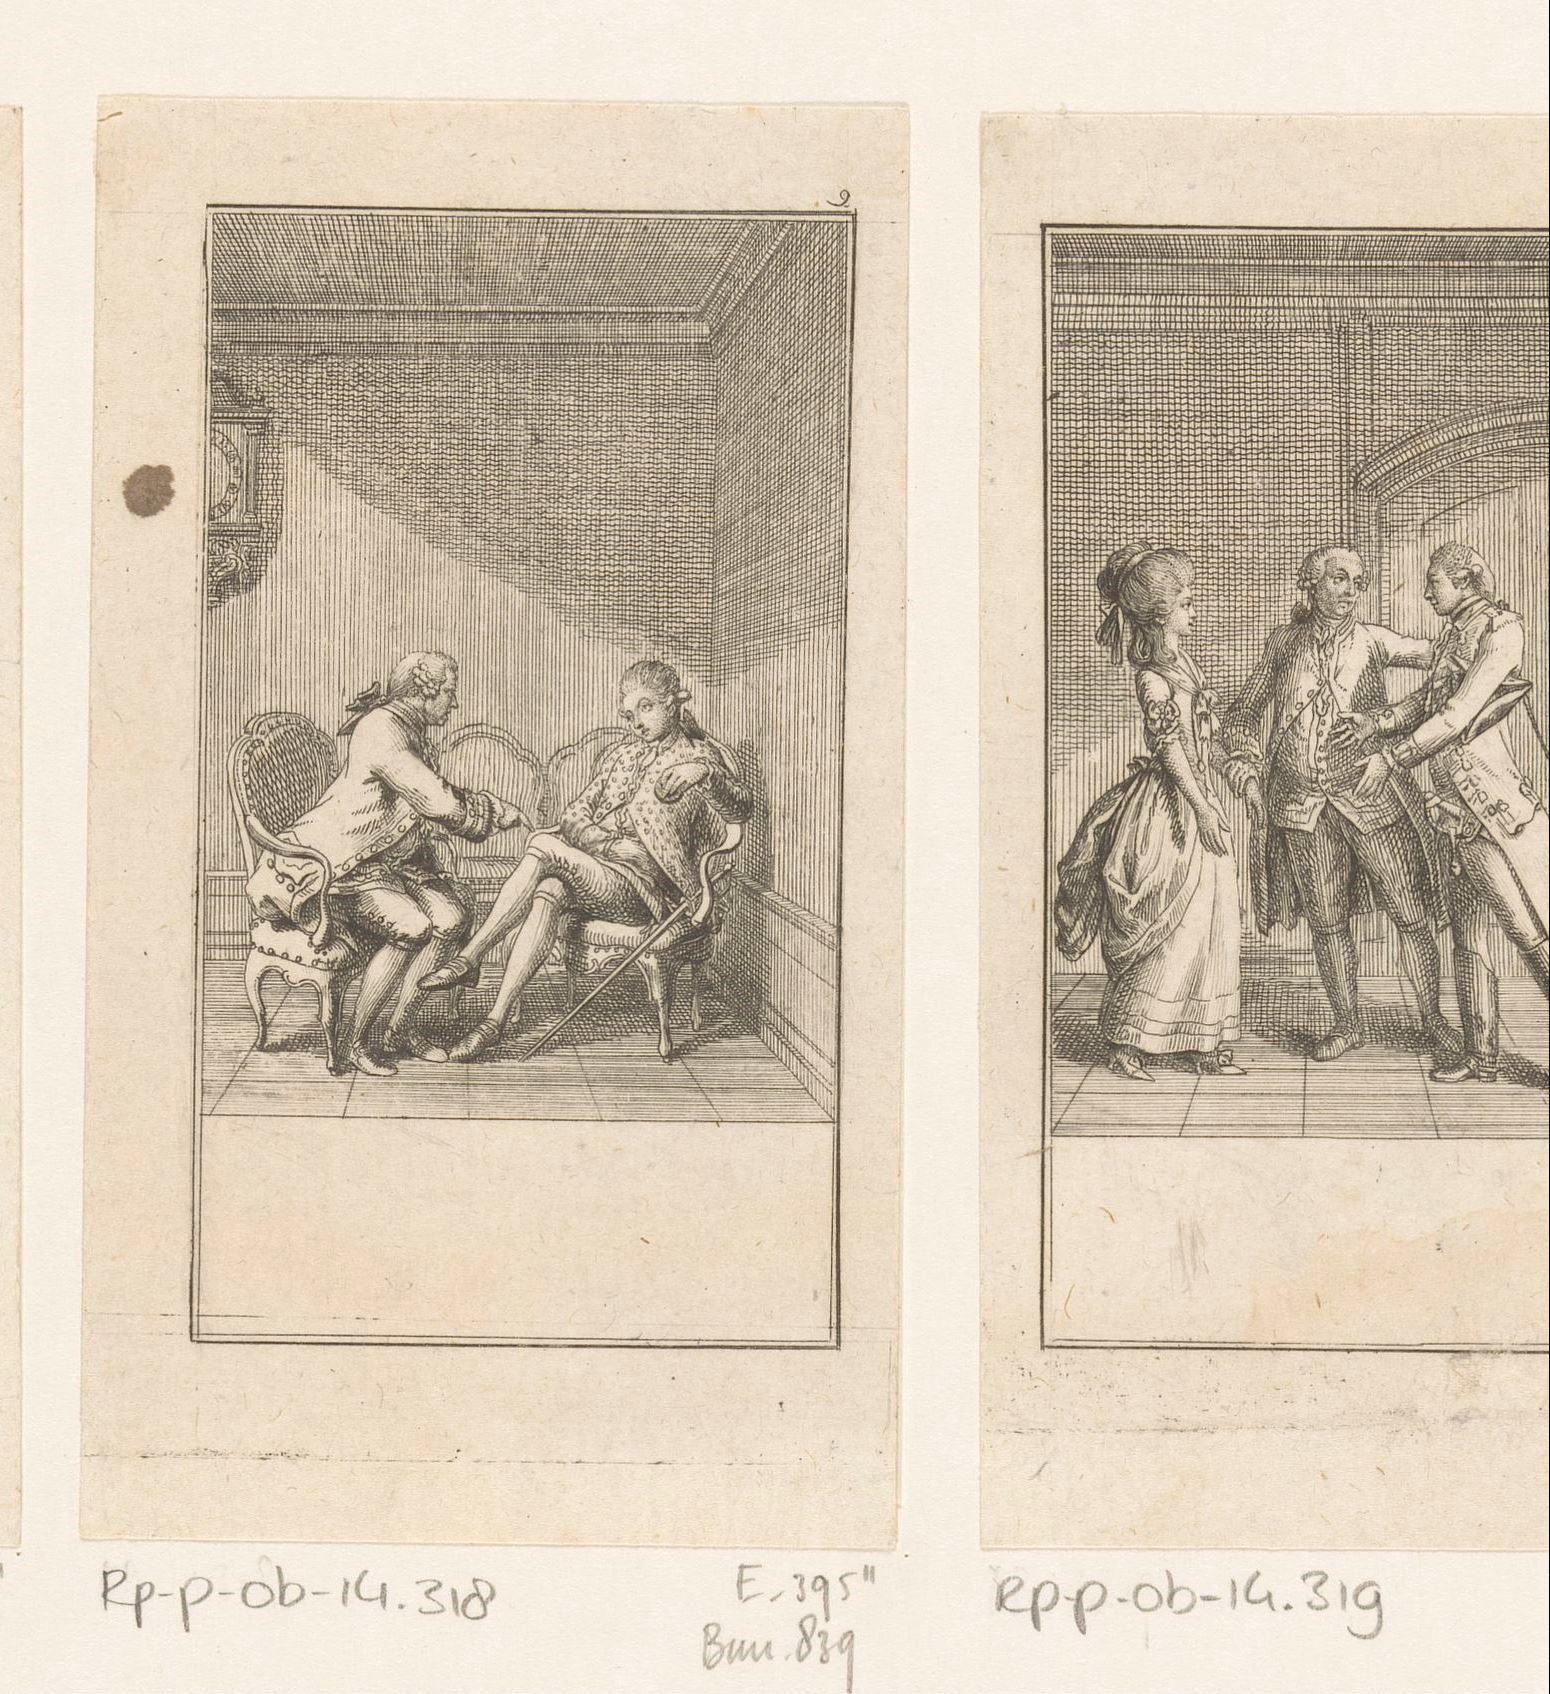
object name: print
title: Reinhard in gesprek met zijn kamerheer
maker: daniel nikolaus chodowiecki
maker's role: draughtsman, print maker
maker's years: 1726-1801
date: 1781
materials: paper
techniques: etching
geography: berlin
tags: berlin, interior of the house, conversation, dialogue; conversation piece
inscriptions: collector's mark: Lugt 2228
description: Vervaardigd voor G. F. W. Grossmann's 'Nicht mehr als sechs Schüsseln'. Een latere staat gebruikt in: Königl. Grossbr. Genealogischer Kalender auf das Jahr 1782. Lauenburger: J.G. Berenberg, 1782.